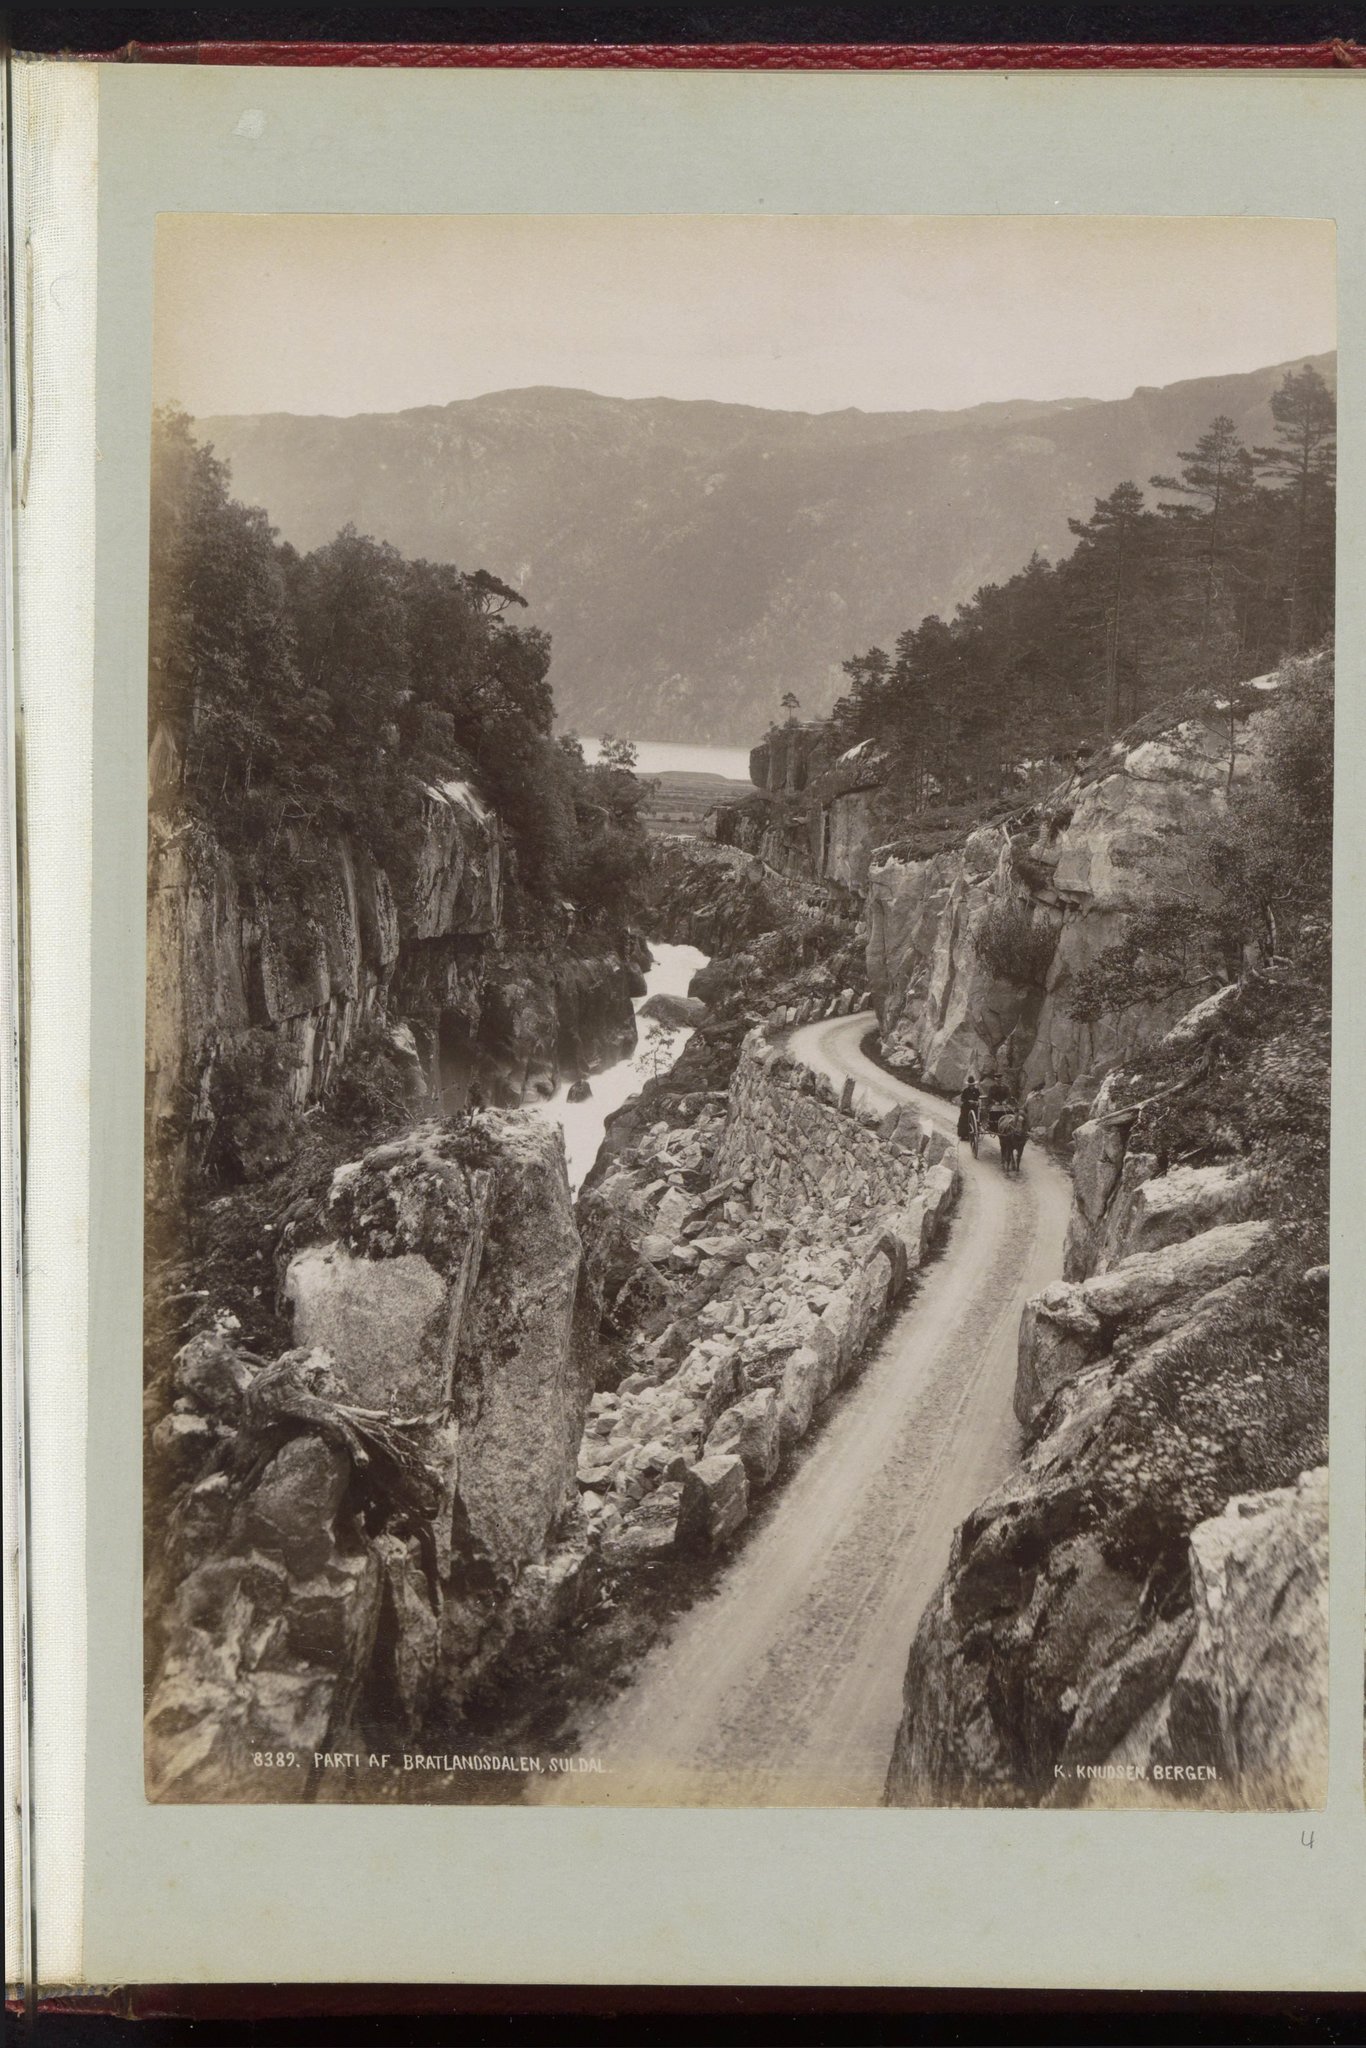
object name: photograph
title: Gezicht op een weg en en rivier door het Brattlanddal in Noorwegen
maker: knud knudsen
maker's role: fotograaf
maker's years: 1832-1915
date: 1870-1900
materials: photographic support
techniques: albumen print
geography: norway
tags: ravine, chasm, abyss, canyon, norway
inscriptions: number: ‘8389’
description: Onderdeel van Fotoalbum met opnames van bezienswaardigheden in Europa, Trinidad, Haïti, Martinique en Suriname.